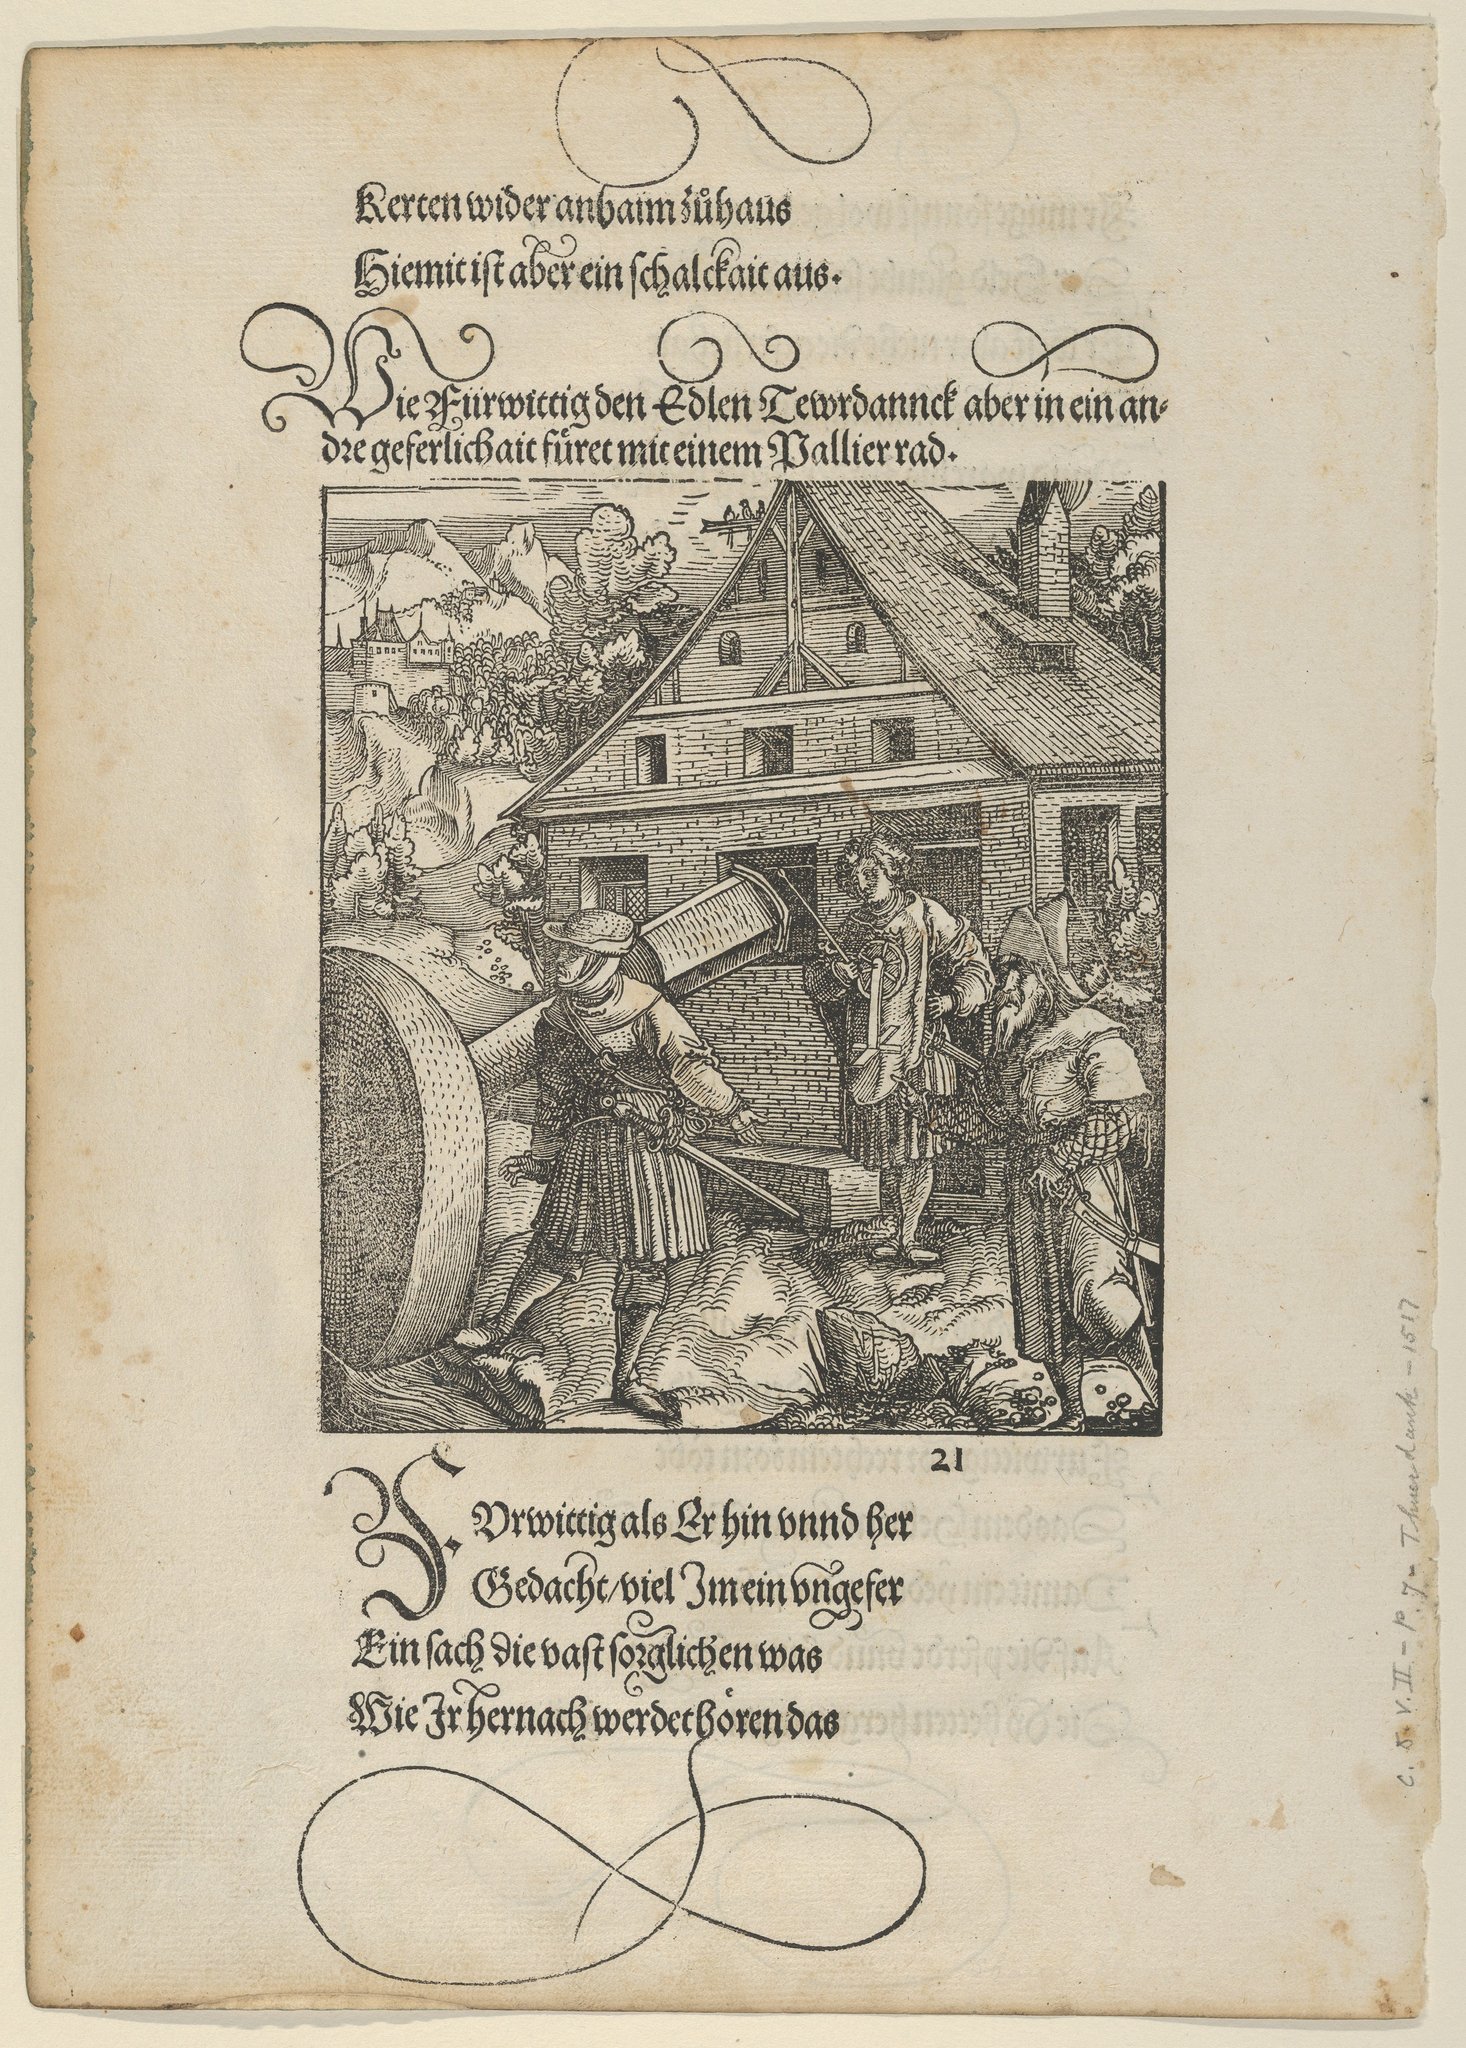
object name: print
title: Urged by Fürwittig, Theurerdanck Tries to Manipulate a Polishing Stone, from "Theurerdanck"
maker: hans schäufelein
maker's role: artist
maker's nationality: german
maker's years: 1480-1540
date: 1517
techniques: woodcut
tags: buildings,soldiers,men